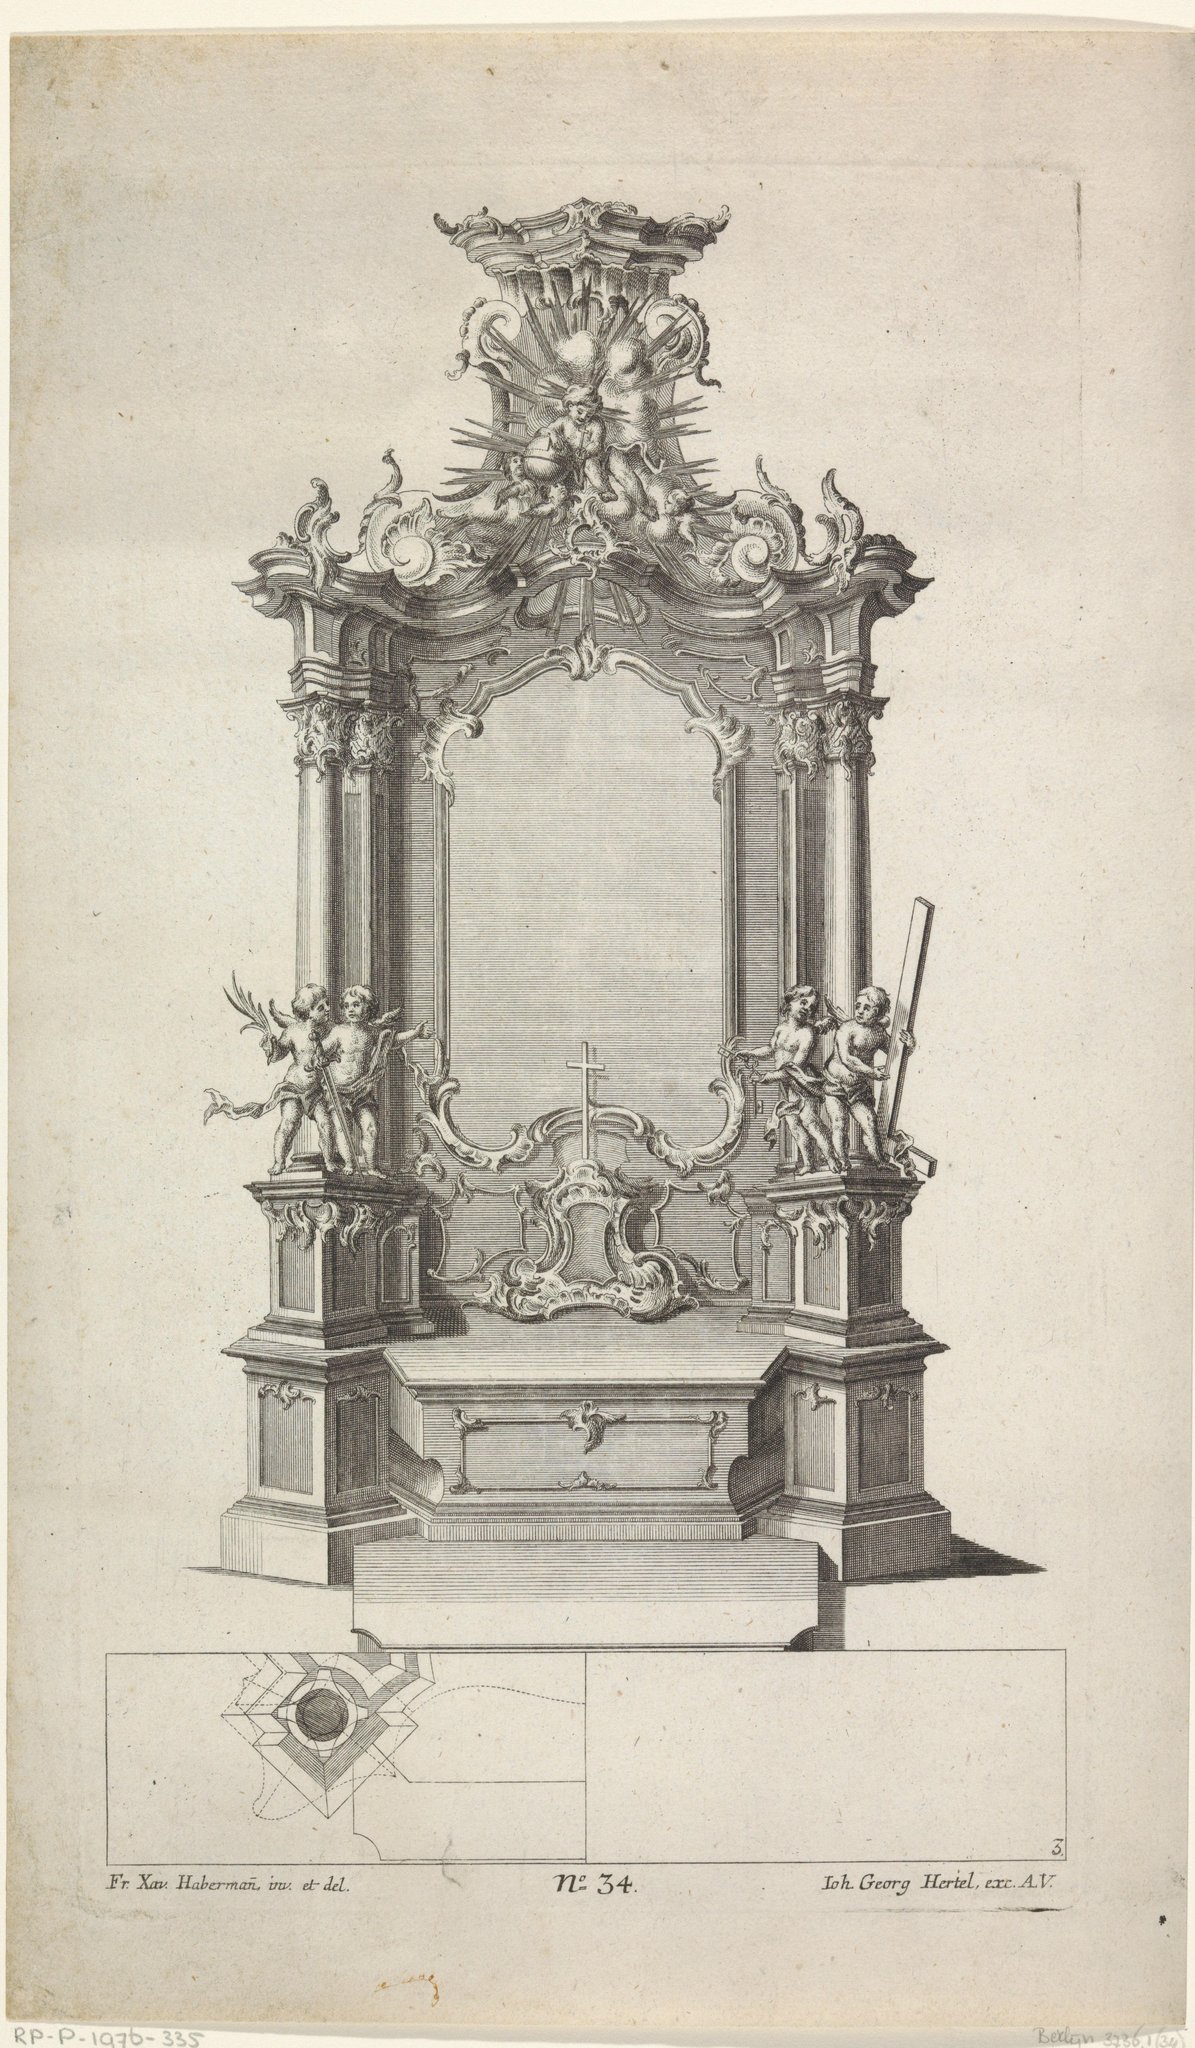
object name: ornament print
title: Ontwerpen voor altaren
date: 1740-1745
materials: paper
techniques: engraving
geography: augsburg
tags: altar, cupids: 'amores', 'amoretti', 'putti', the apostle peter, first bishop of rome; possible attributes: book, cock, (upturned) cross, (triple) crozier, fish, key, scroll, ship, tiara, the apostle paul of tarsus; possible attributes: book, scroll, sword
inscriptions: collector's mark: Lugt 2228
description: Ontwerp en plattegrond van altaar met rocaille ornamenten. Links en rechts vier putti met palmtak, zwaard, sleutels en een omgekeerd kruis: de attributen van Petrus en Paulus. Uitgeversnummer 34.